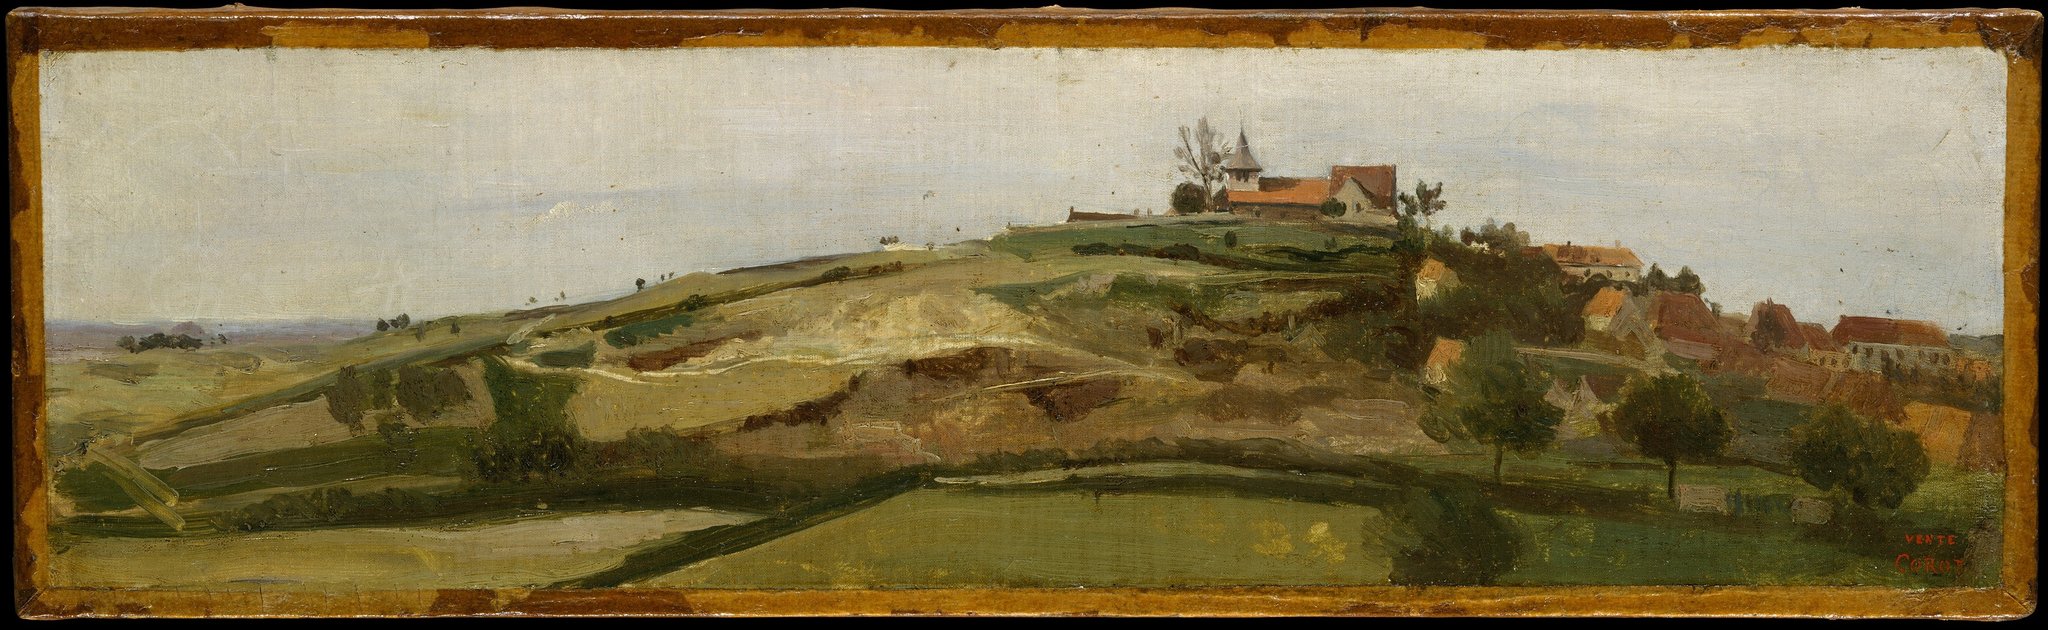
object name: painting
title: View of Lormes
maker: jean-baptiste-camille corot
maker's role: artist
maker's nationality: french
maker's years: 1796-1875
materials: canvas, oil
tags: villages,landscapes